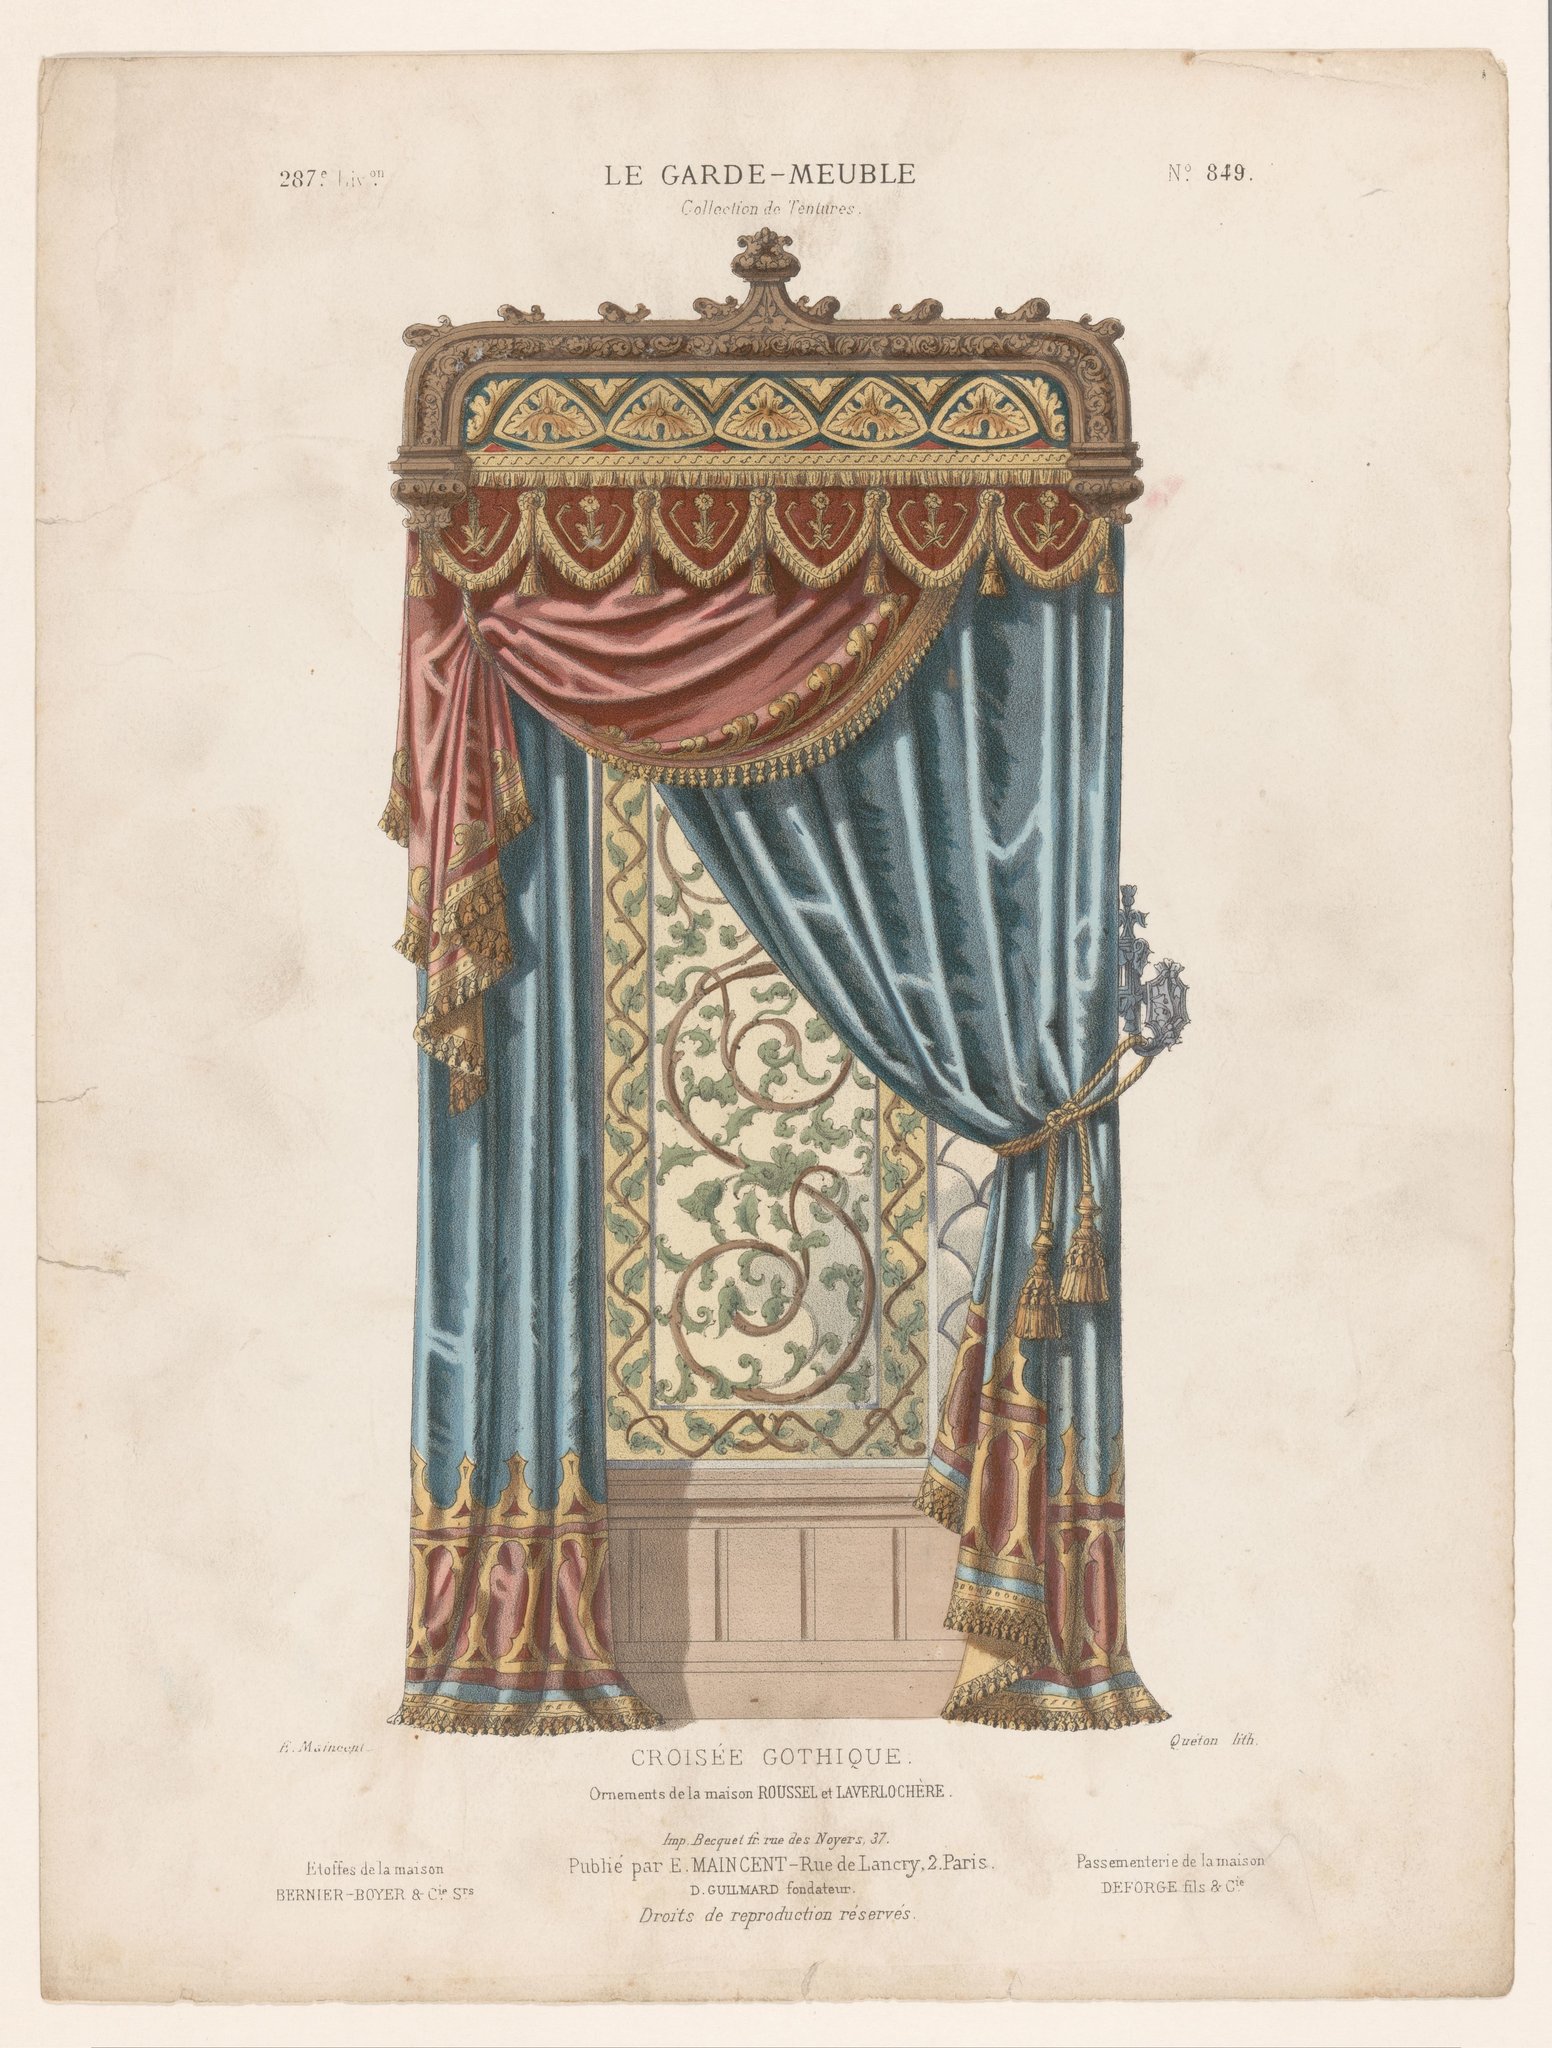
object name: print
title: Le Garde-Meuble / Collection de Tentures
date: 1885-1895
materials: paper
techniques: hand coloring, lithograph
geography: paris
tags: window, hangings and drapery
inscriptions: : ‘Droits de reproduction réservés.’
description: Kruisvenster met gedrapeerde gordijnen in gotische stijl. Prent uit 287e Livraison.